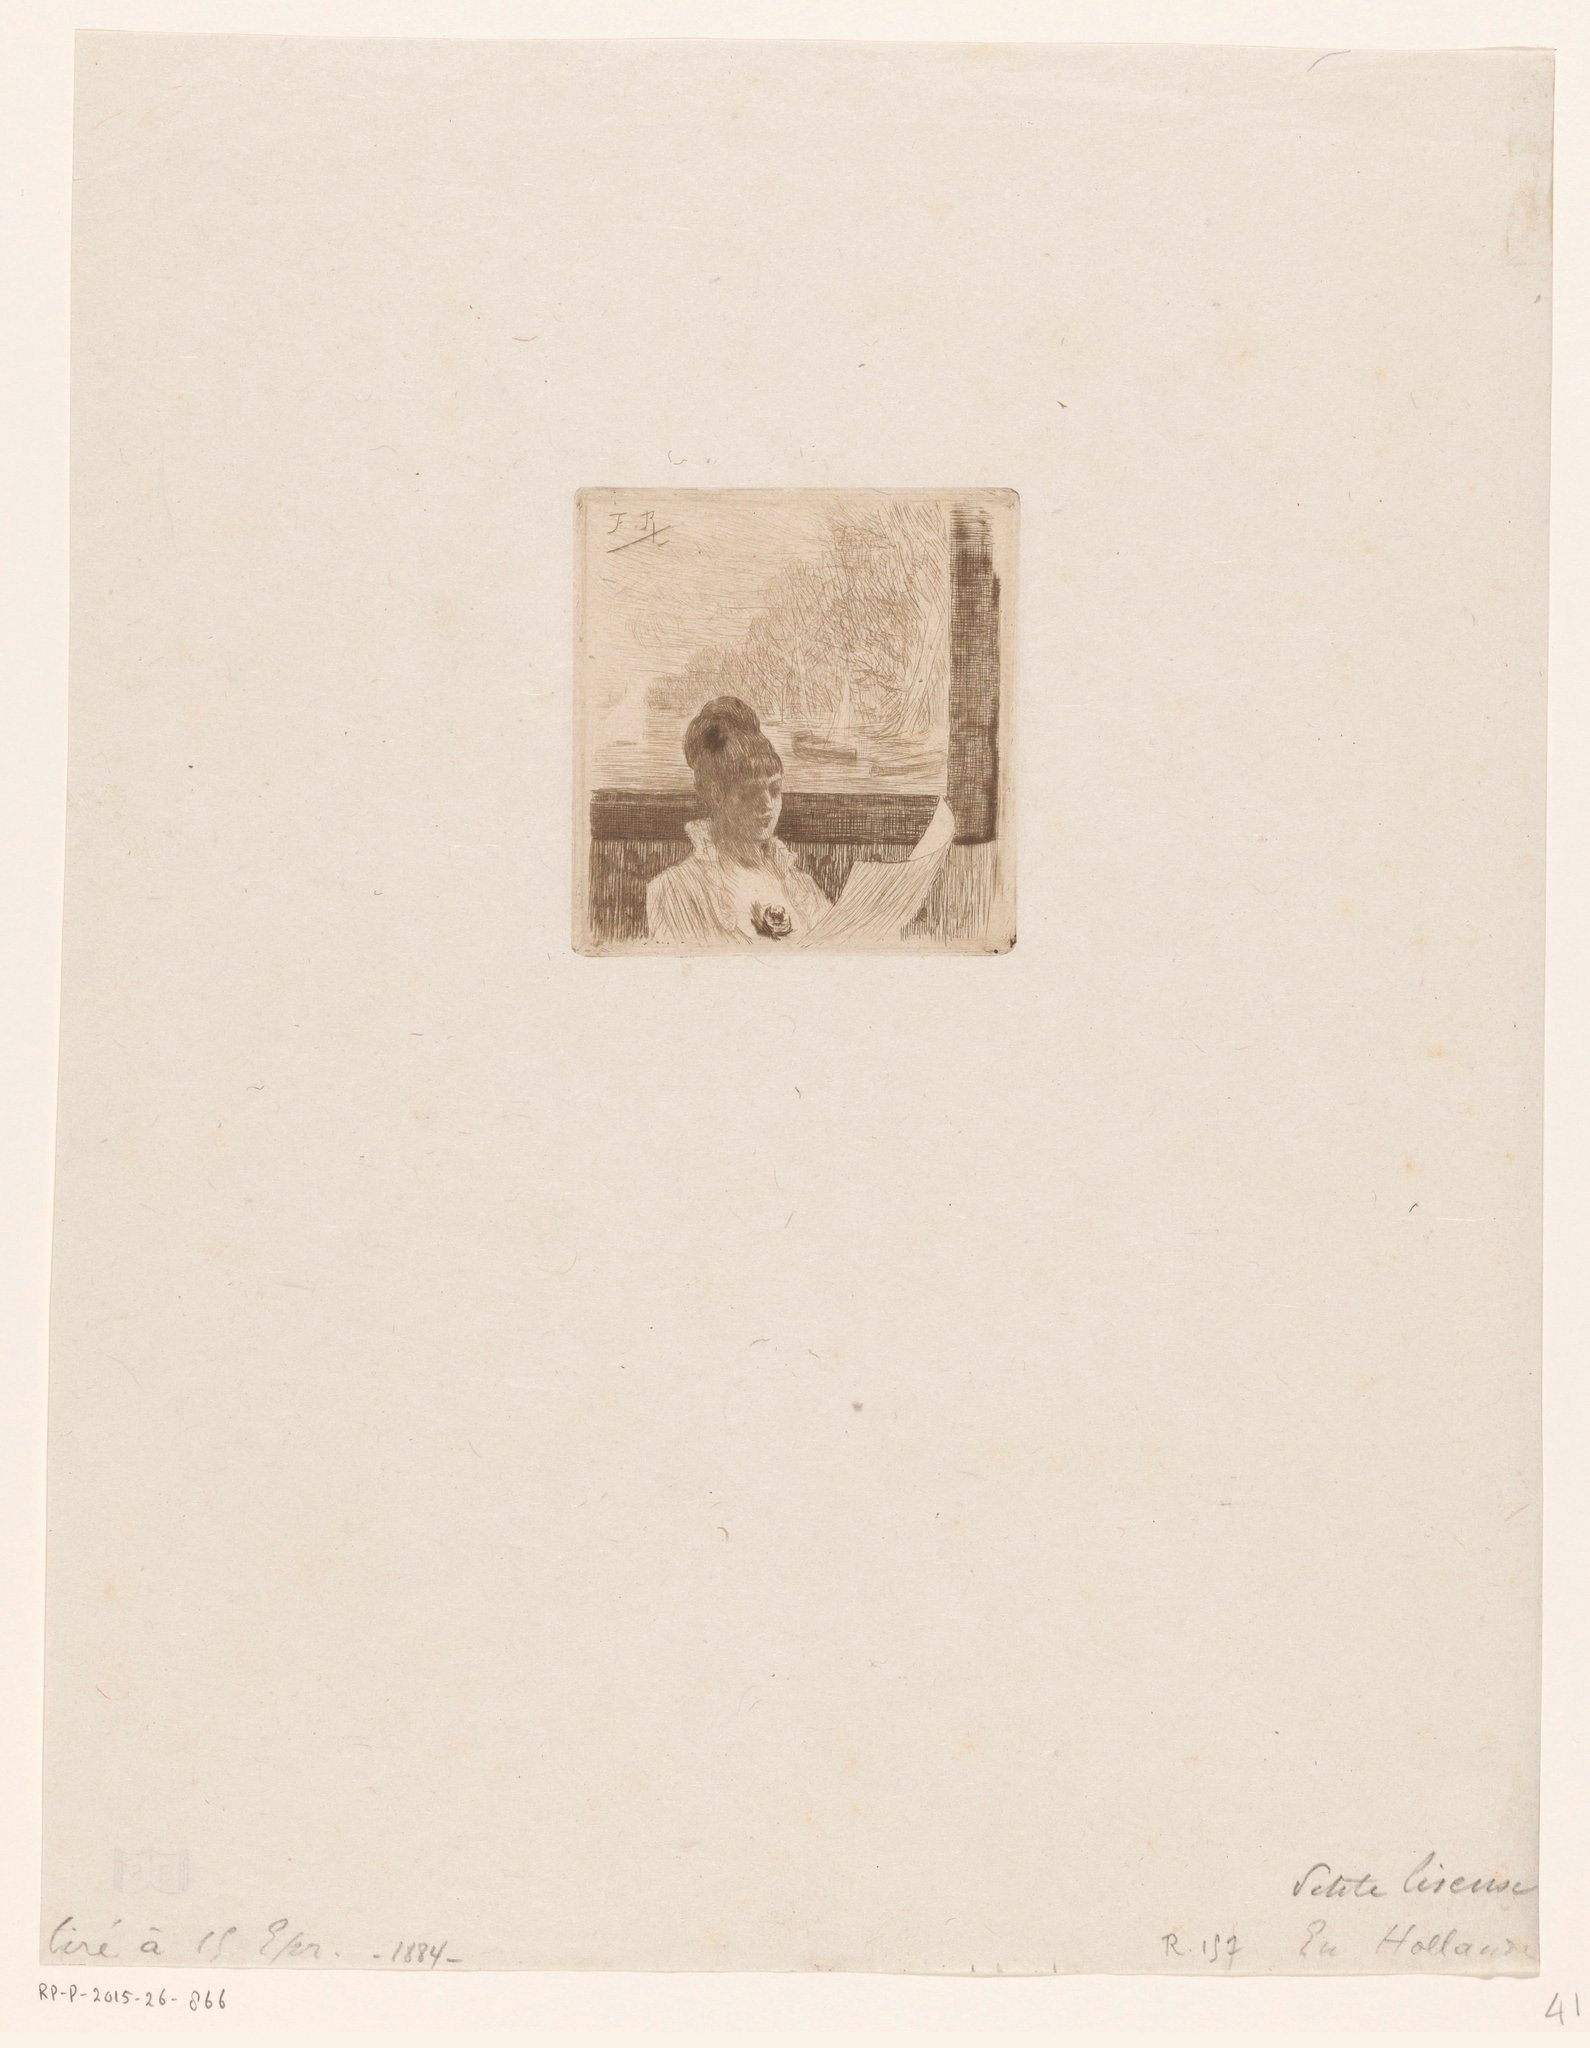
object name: print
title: Petite liseuse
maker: félicien rops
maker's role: draughtsman, print maker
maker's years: 1833-1898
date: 1879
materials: paper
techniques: drypoint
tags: reading, ships (in general)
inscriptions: collector's mark: Lugt 2228, : Lugt 4779, annotation: ‘tiré à 15 Epr. 1884/ petite liseuse/ R. 157 En Hollande’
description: Het raam biedt uitzicht op water met boten.